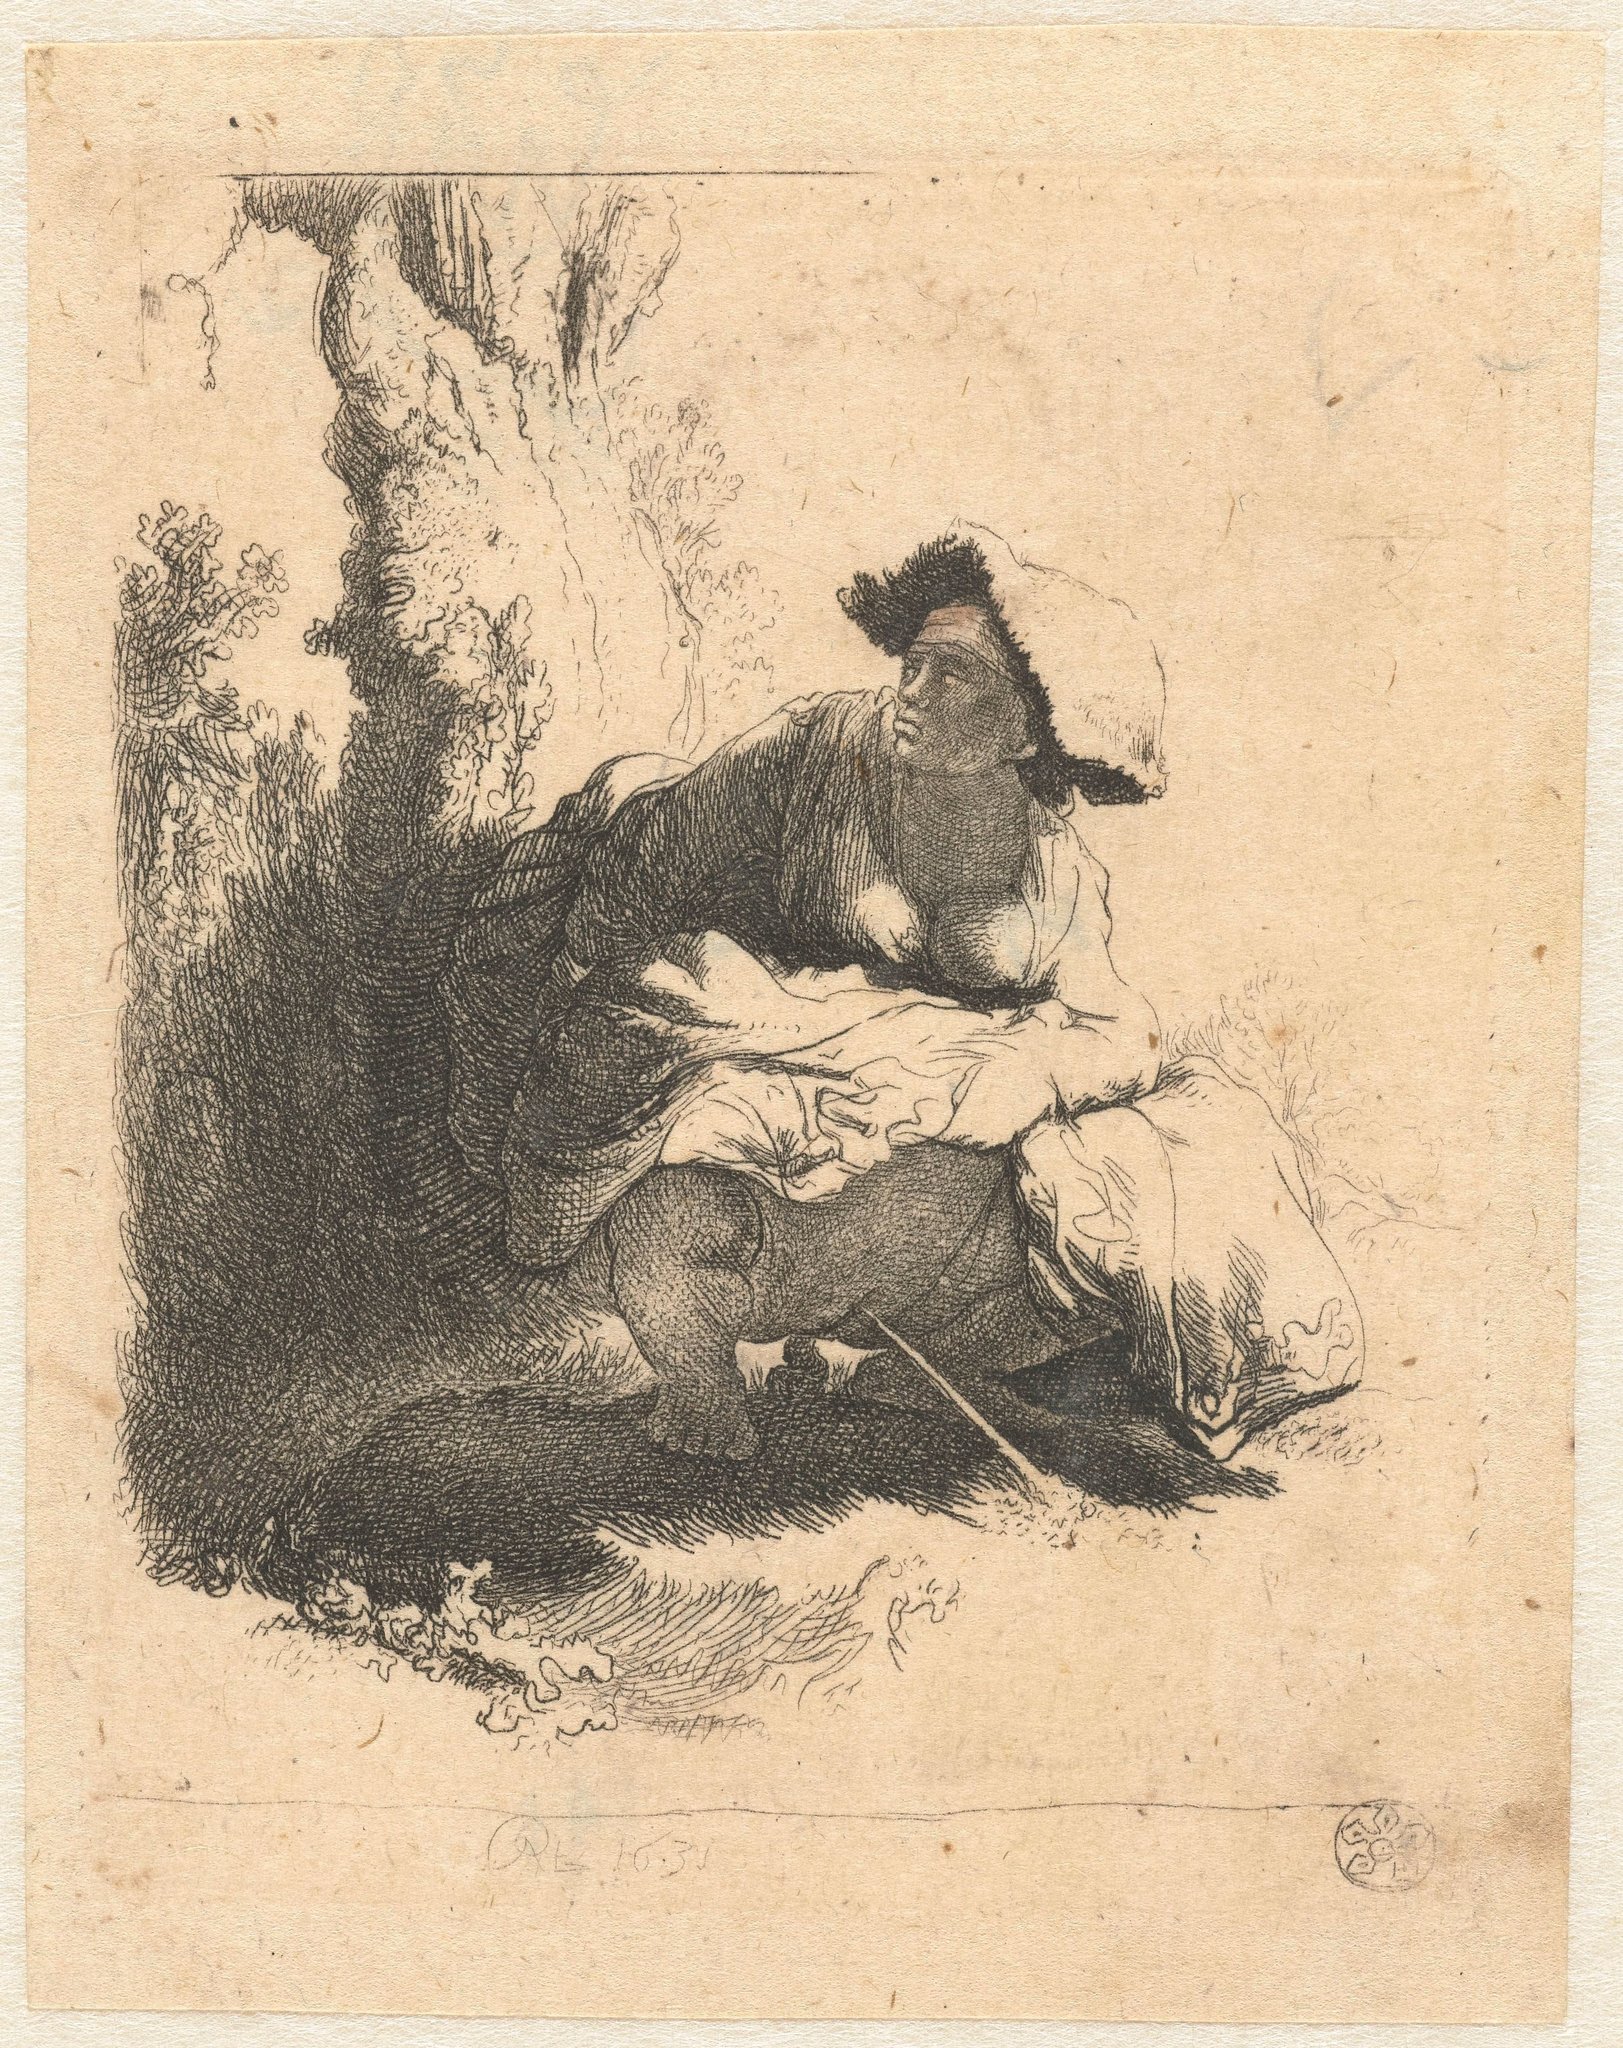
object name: print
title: A woman making water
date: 1631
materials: paper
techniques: etching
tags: adult woman, urination, defecation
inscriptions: collector's mark: Lugt 2228, collector's mark: Lugt 2760